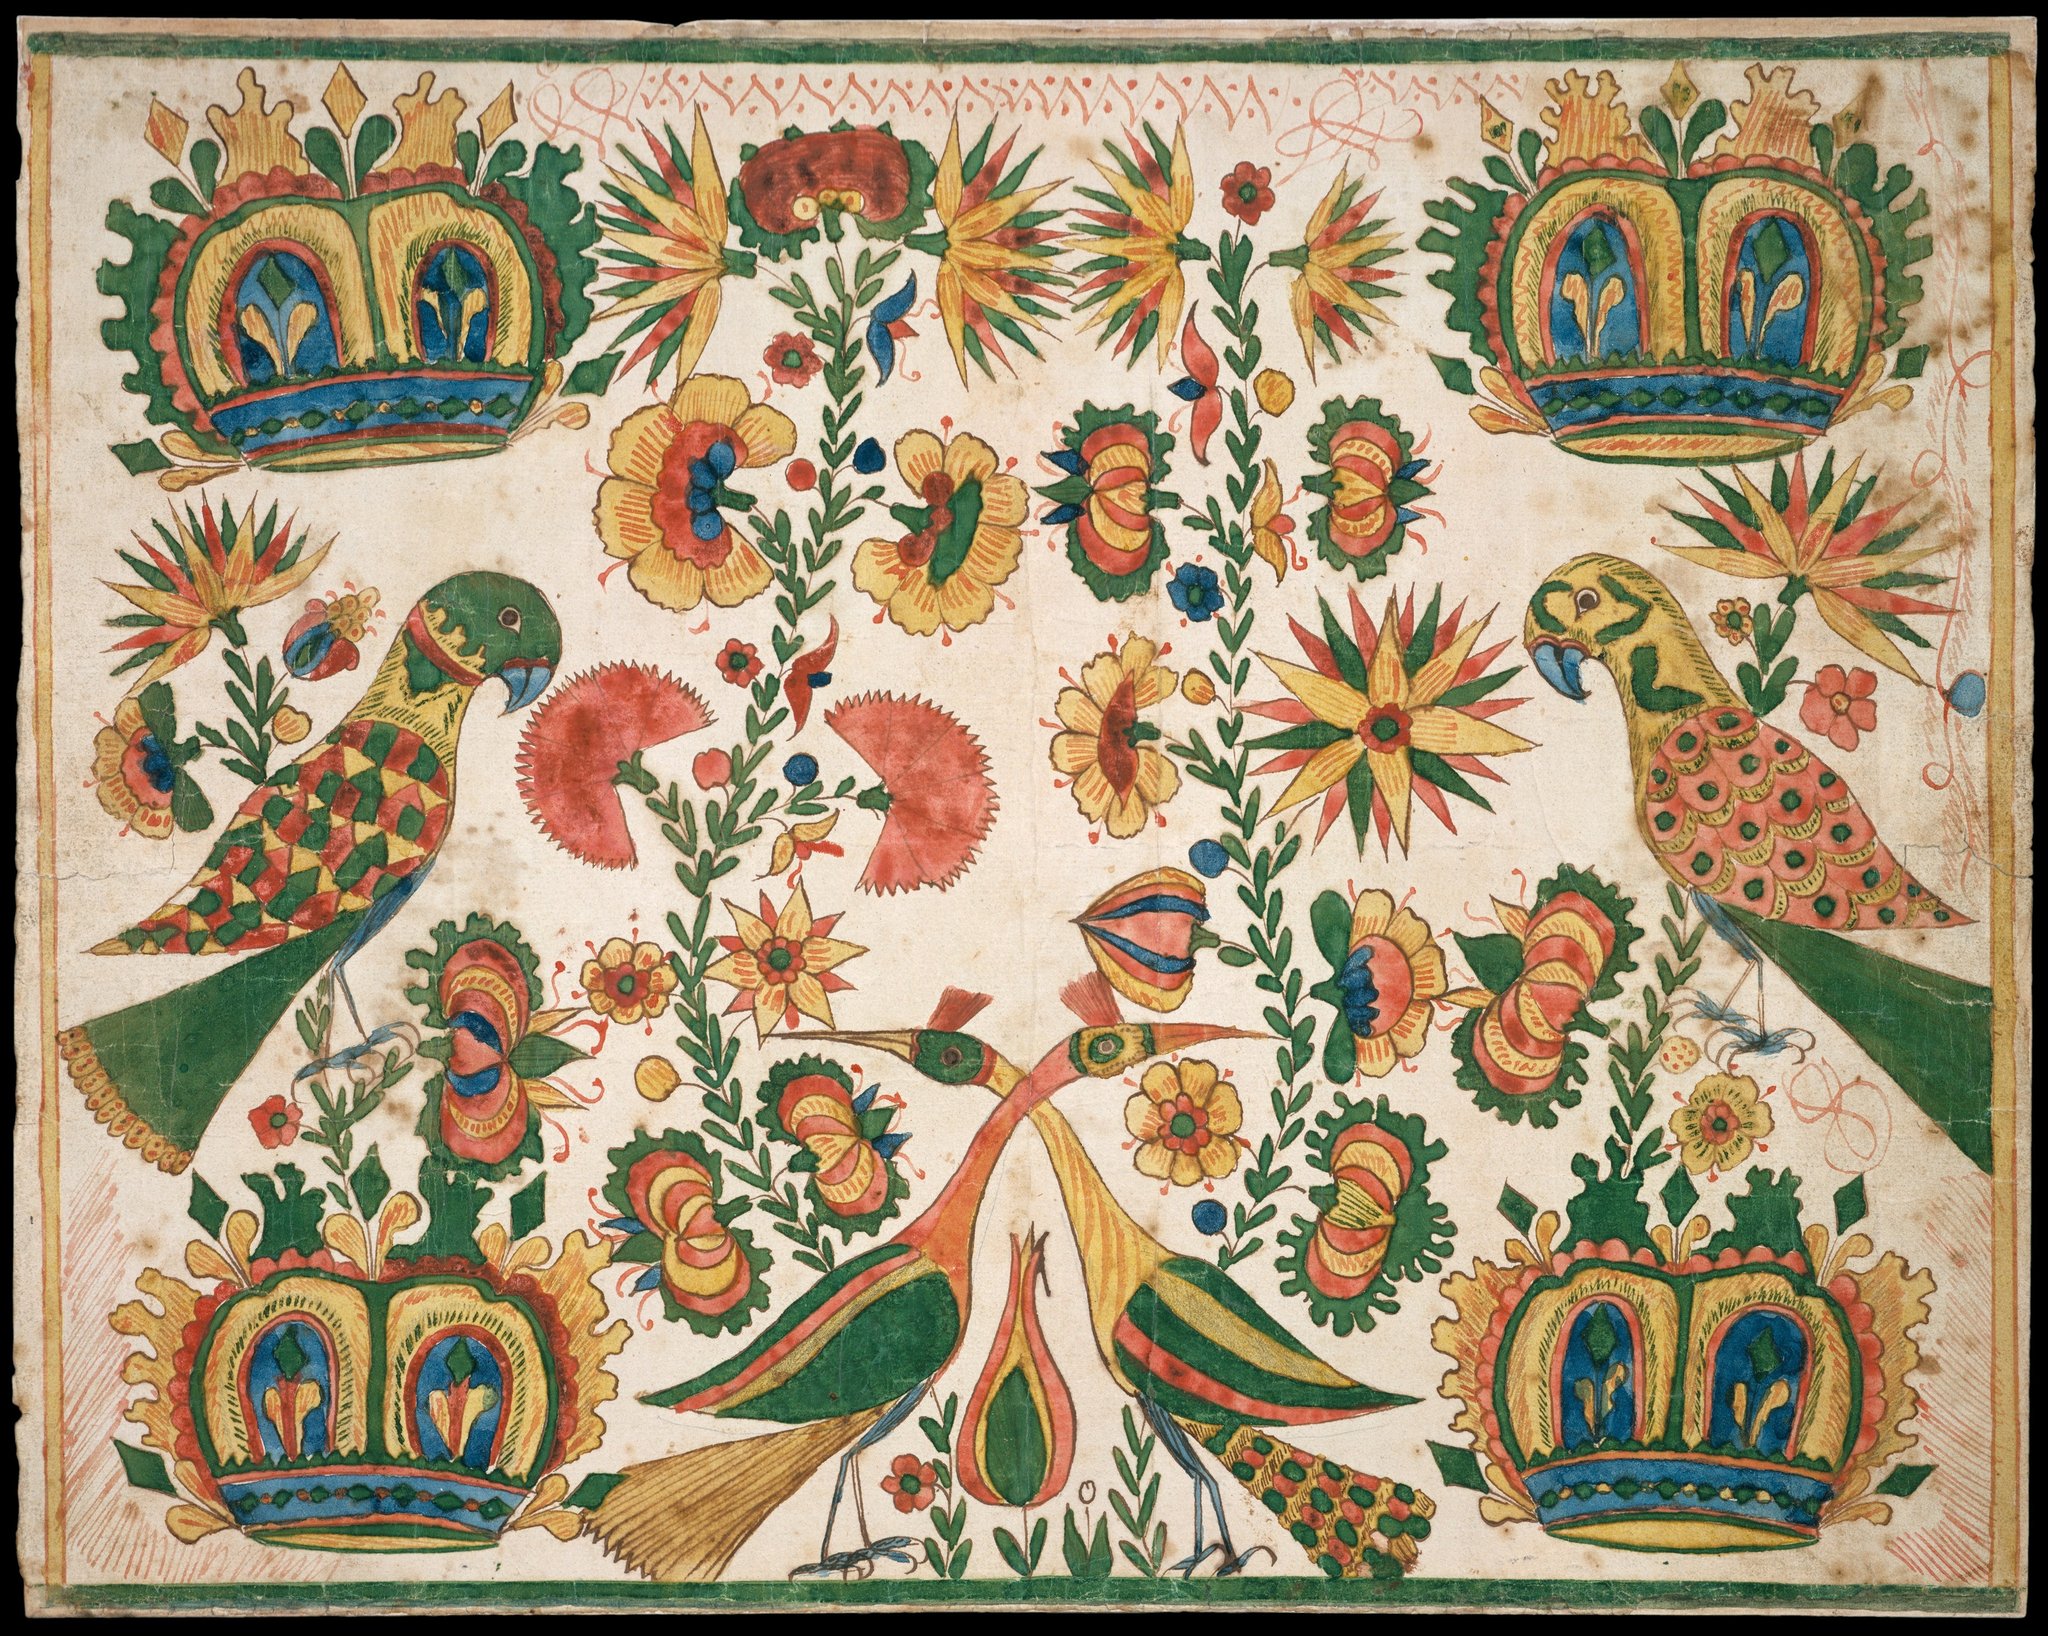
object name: fraktur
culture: american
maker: johann heinrich otto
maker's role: maker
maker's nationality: american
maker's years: 1730-1800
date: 1770-1800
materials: graphite, ink, iron, paper, watercolor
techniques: pen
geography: united states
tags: parrots,peacocks,flowers